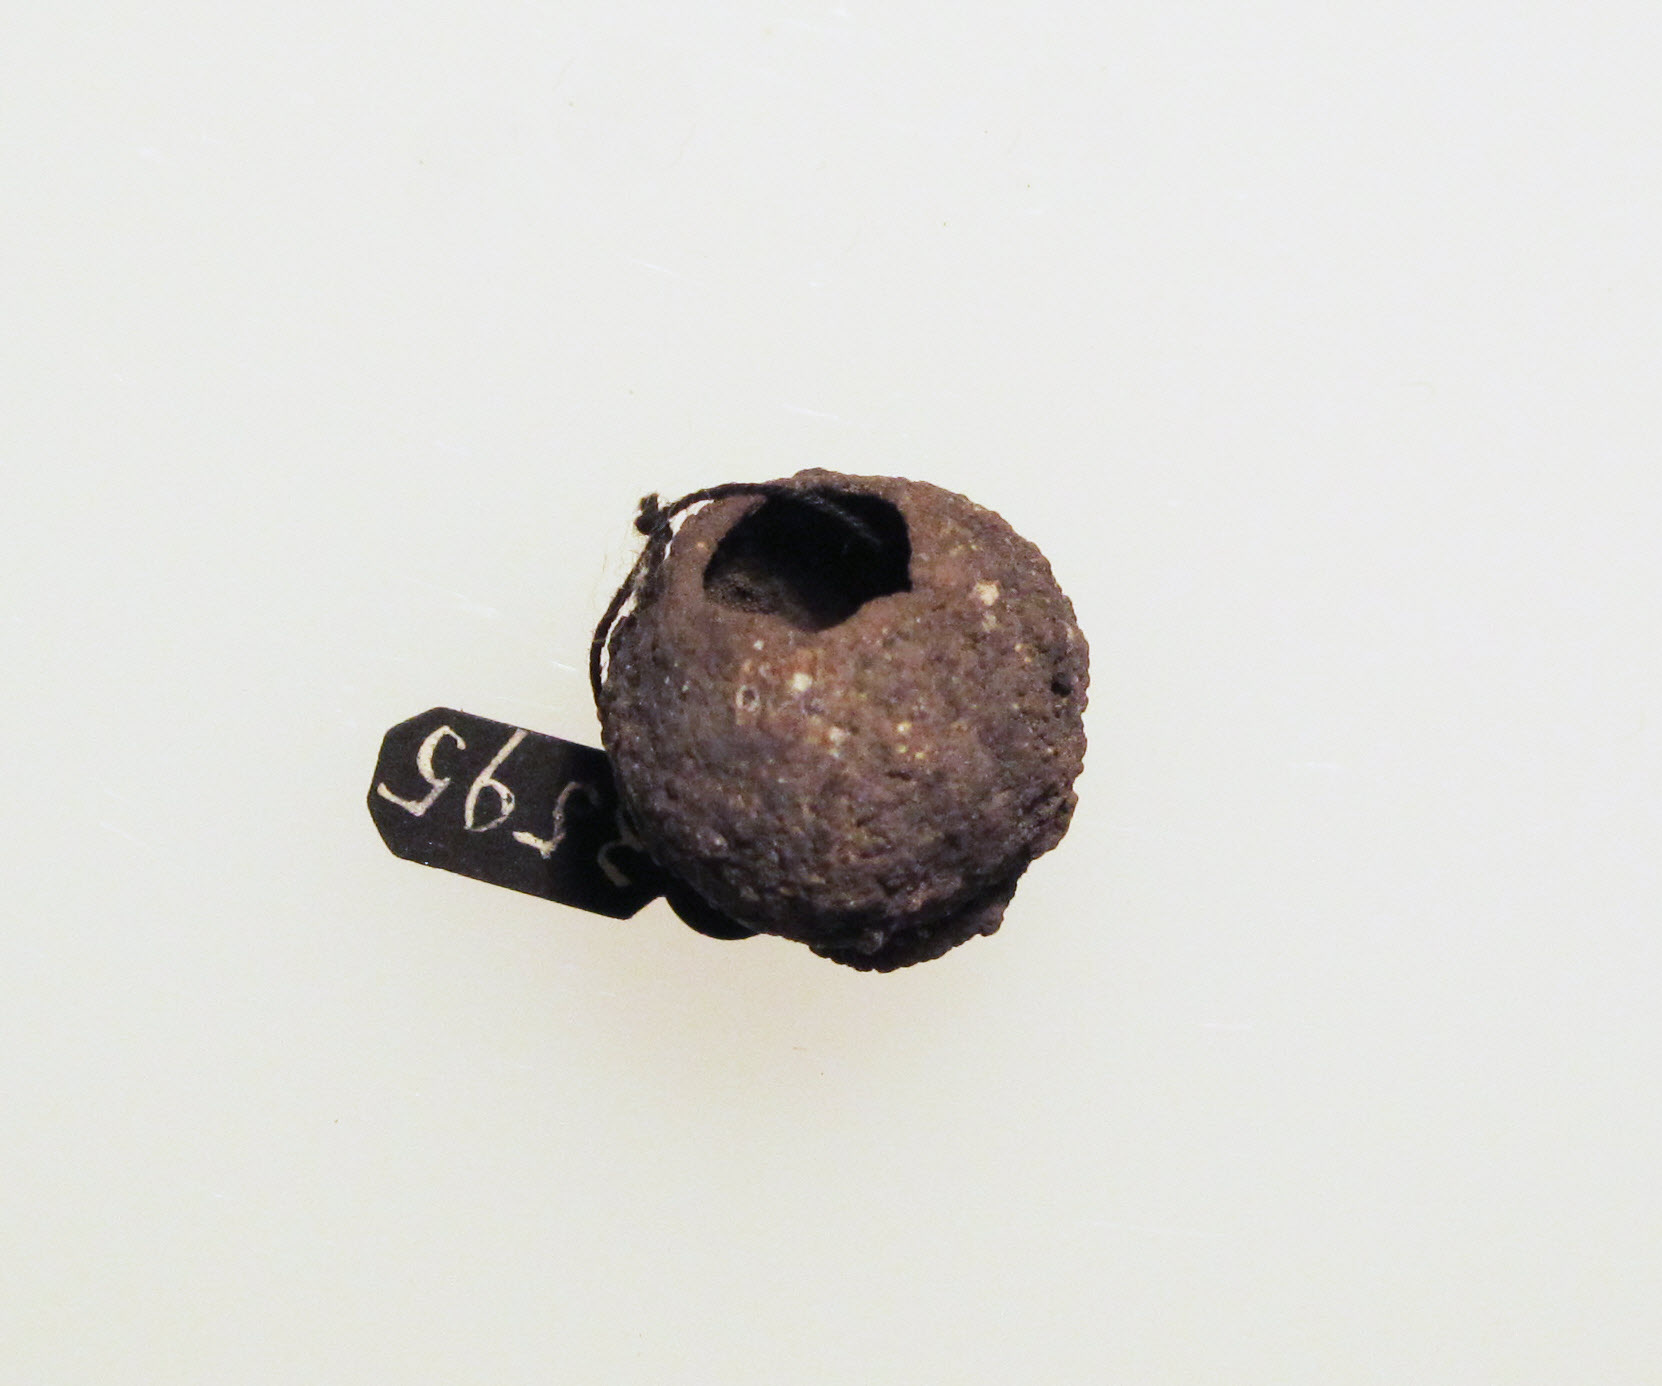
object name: bead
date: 7000 BCE-330 CE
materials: silver